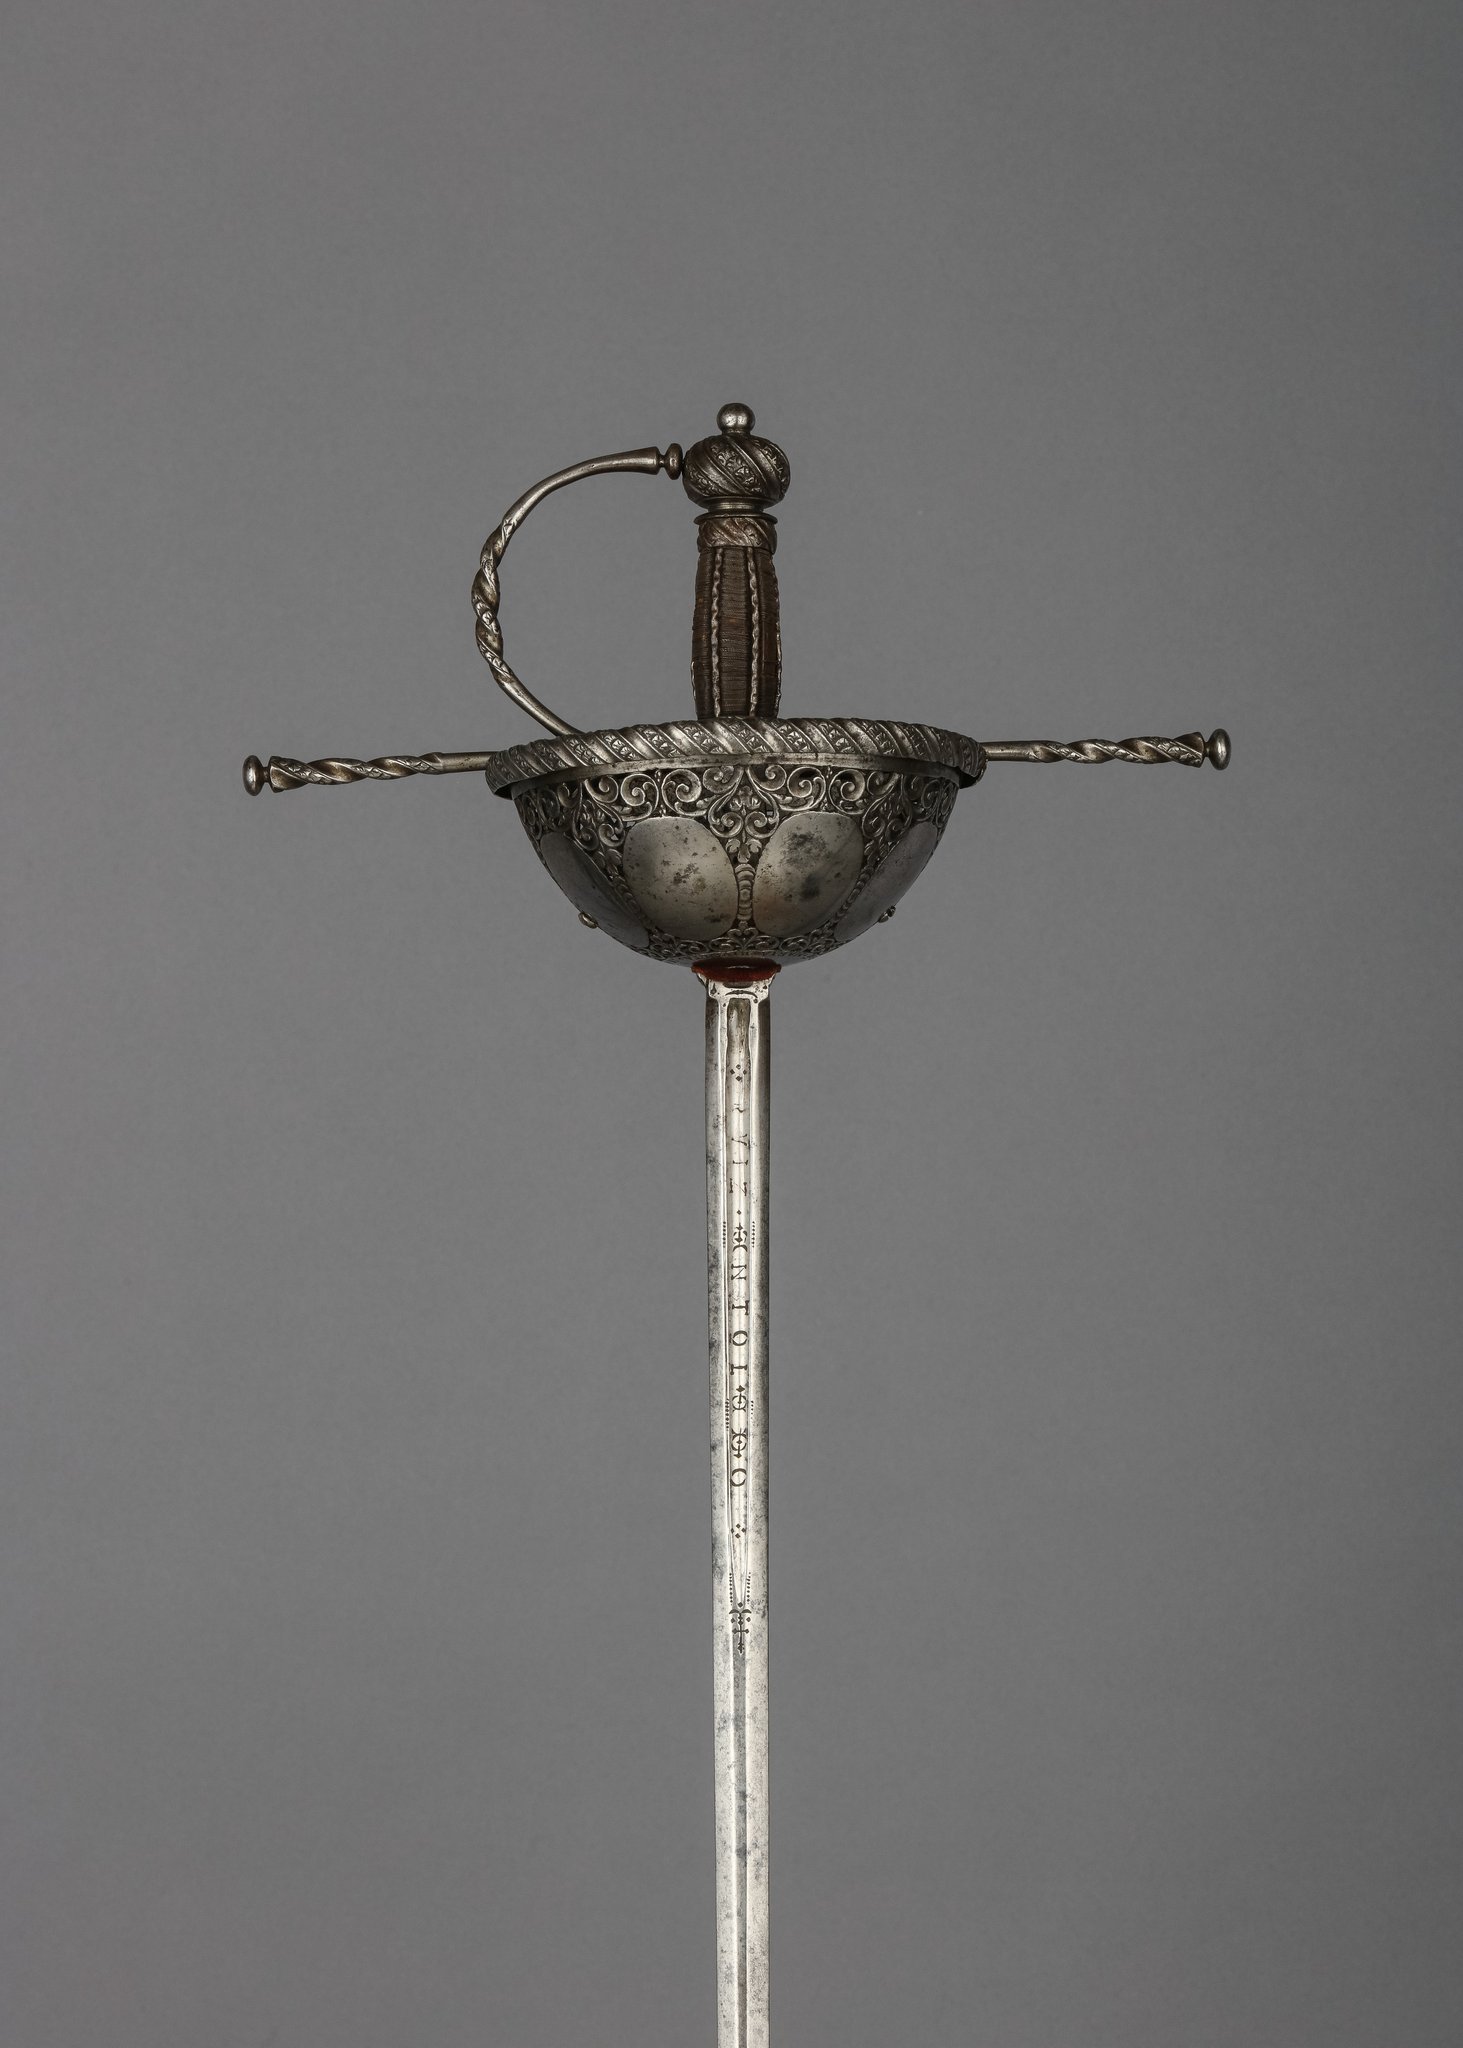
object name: cup hilted rapier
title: Cup-Hilted Rapier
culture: italian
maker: francesco maria rivolta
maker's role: hilt maker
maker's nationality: italian, milan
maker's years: 1650-1700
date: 1670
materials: iron, steel, textile, metal, wood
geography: italy